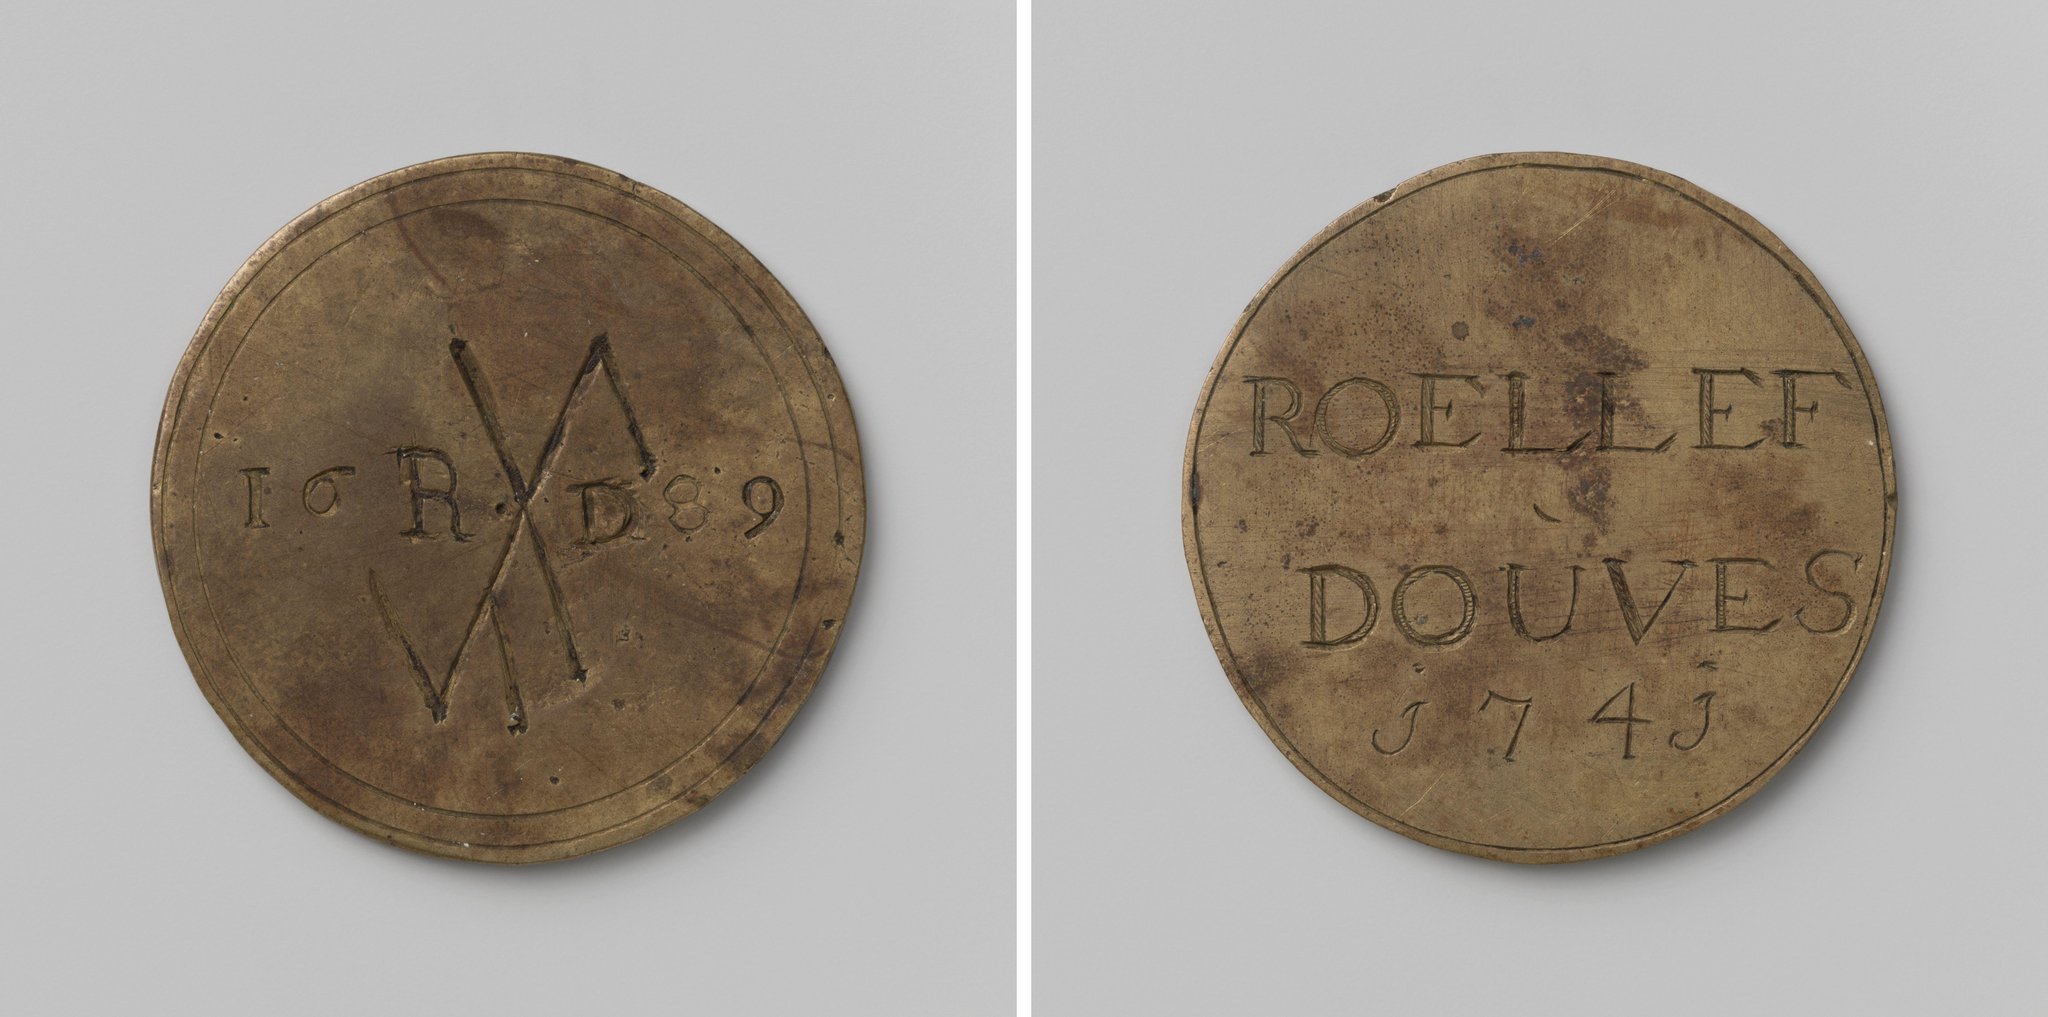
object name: medal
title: Onbekend gilde, gildepenning van Roellef Douves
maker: Anonymous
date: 1741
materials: brass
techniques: engraving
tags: roellef douves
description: Messing penning. Voorzijde: huismerk tussen letters R en D en jaartal. Keerzijde: opschrift